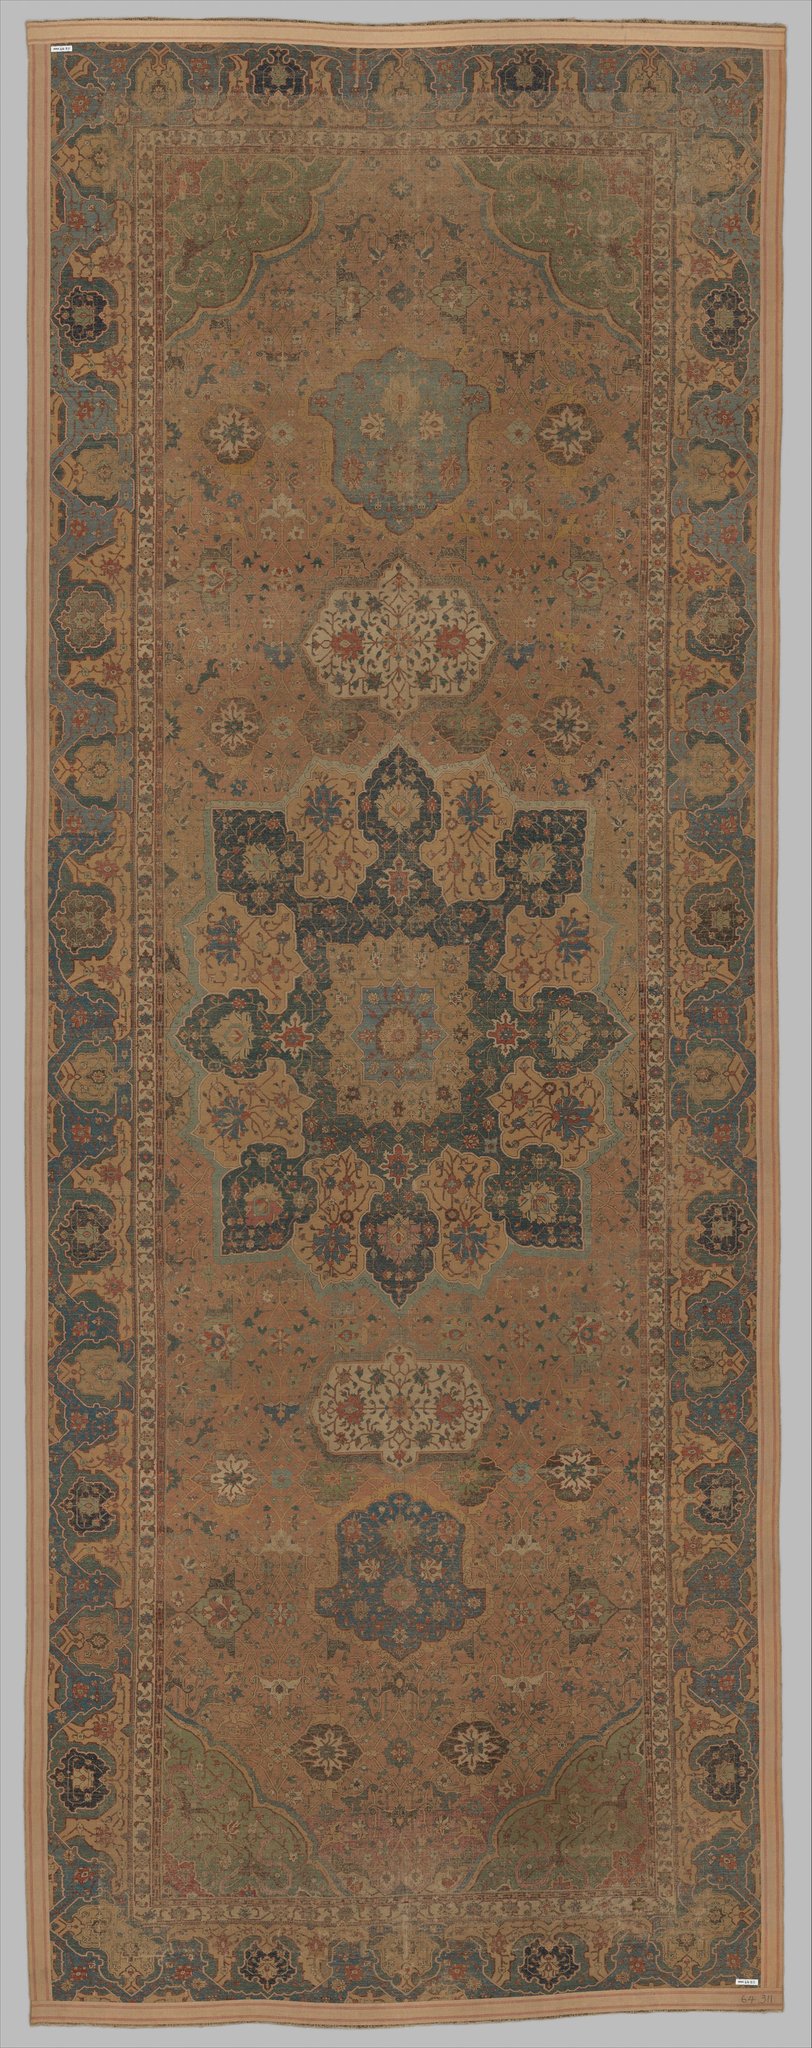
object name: carpet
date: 1501-1600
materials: cotton, wool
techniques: asymmetrically knotted pile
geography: northwestern iran